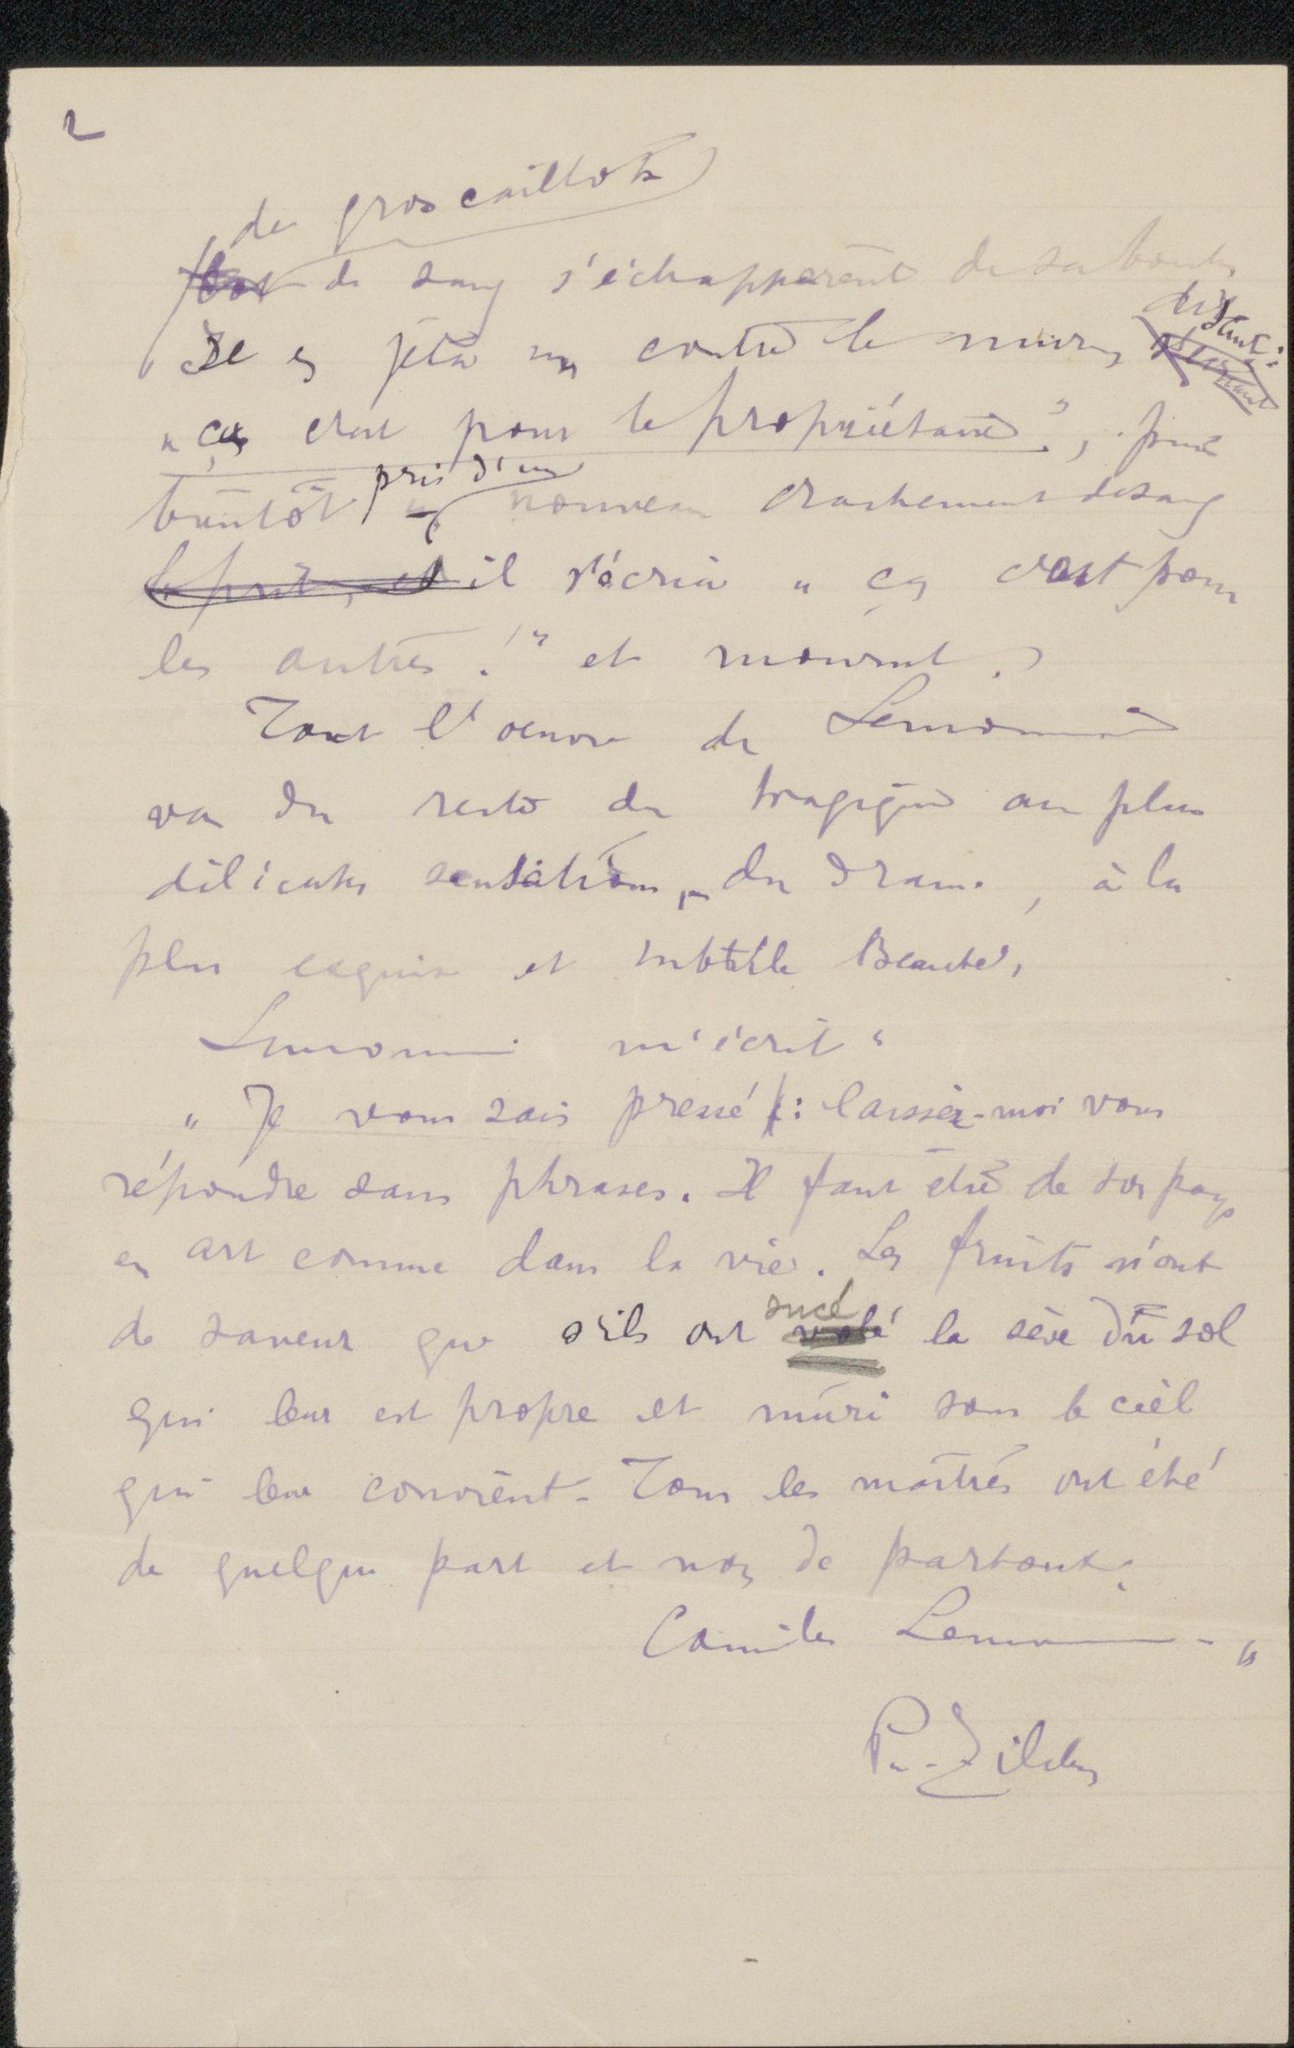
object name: aantekening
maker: philip zilcken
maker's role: draughtsman, painter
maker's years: 1857-1930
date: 1867-1930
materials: ink, paper, pencil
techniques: pen, writing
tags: camille lemonnier, sander pierron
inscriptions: collector's mark: ‘RPK’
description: Aantekening is bewaard bij correspondentie van Sander Pierron aan Philip Zilcken.